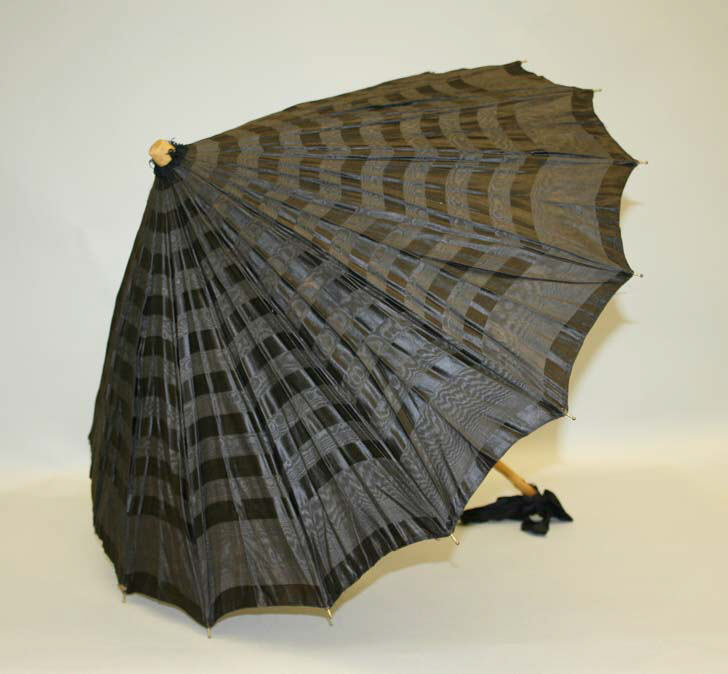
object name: parasol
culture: american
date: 1870-1889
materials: silk, wood